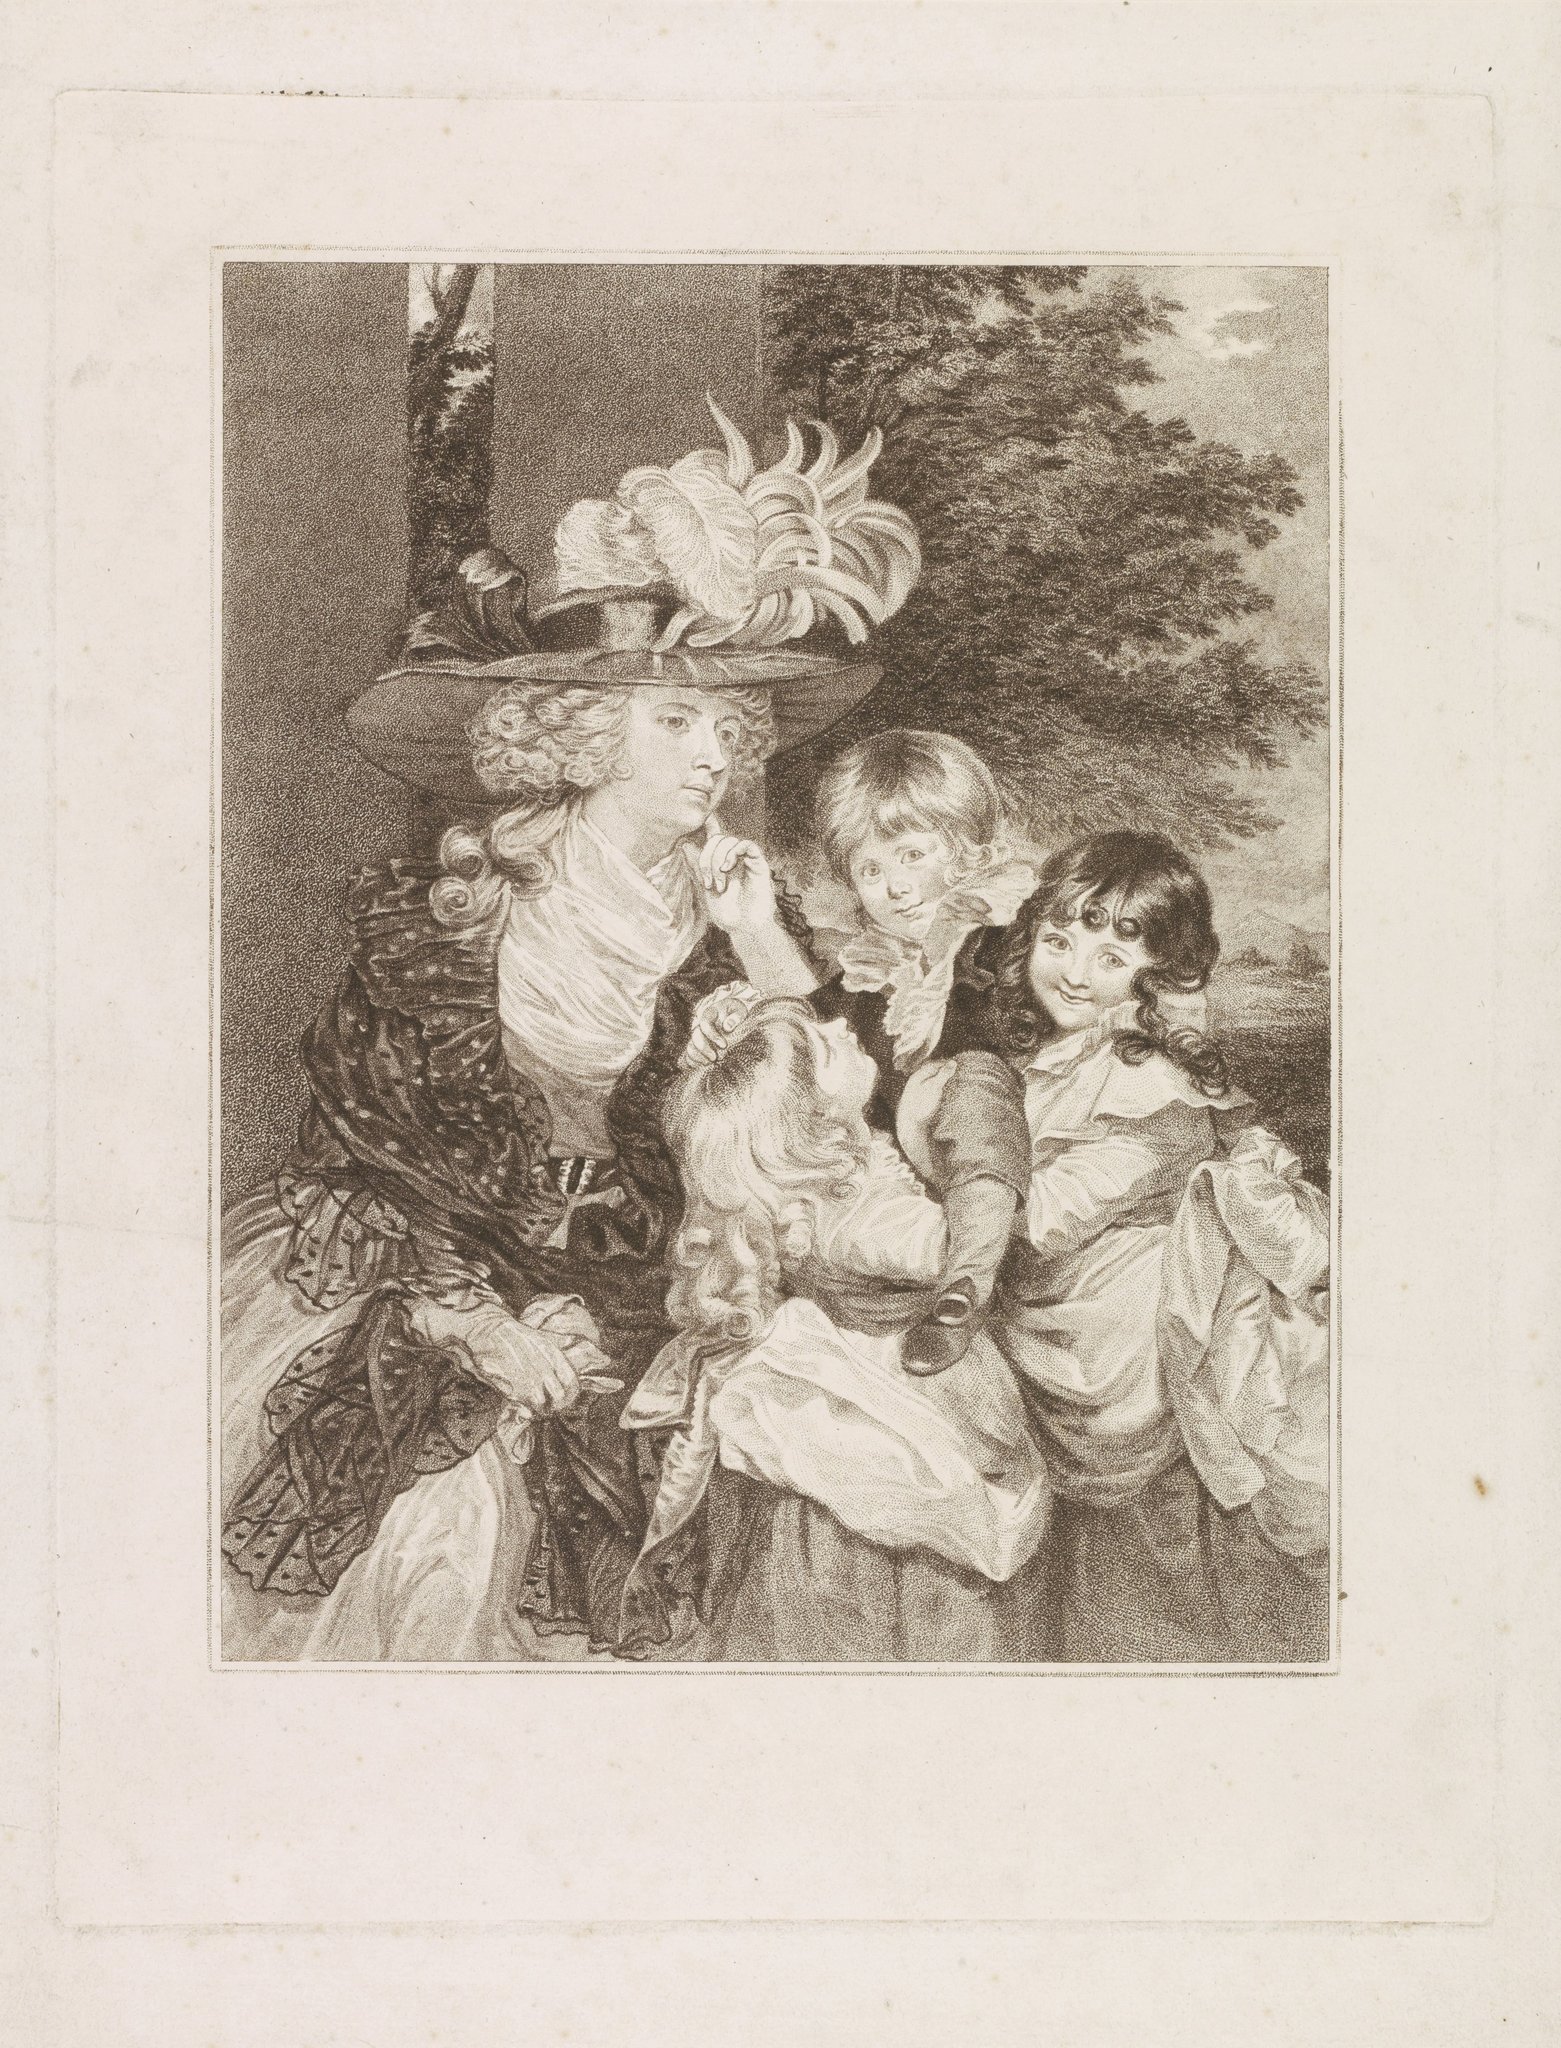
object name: print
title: Portret van Lady Smith en haar drie kinderen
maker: francesco bartolozzi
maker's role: draughtsman, print maker, publisher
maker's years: 1727-1815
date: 1738-1815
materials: paper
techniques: etching, engraving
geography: italy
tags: mother and child(ren), woman and child(ren) (family group)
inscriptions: collector's mark: Lugt 2760, collector's mark: Lugt 2228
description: Portret van Lady Smith en haar drie kinderen.